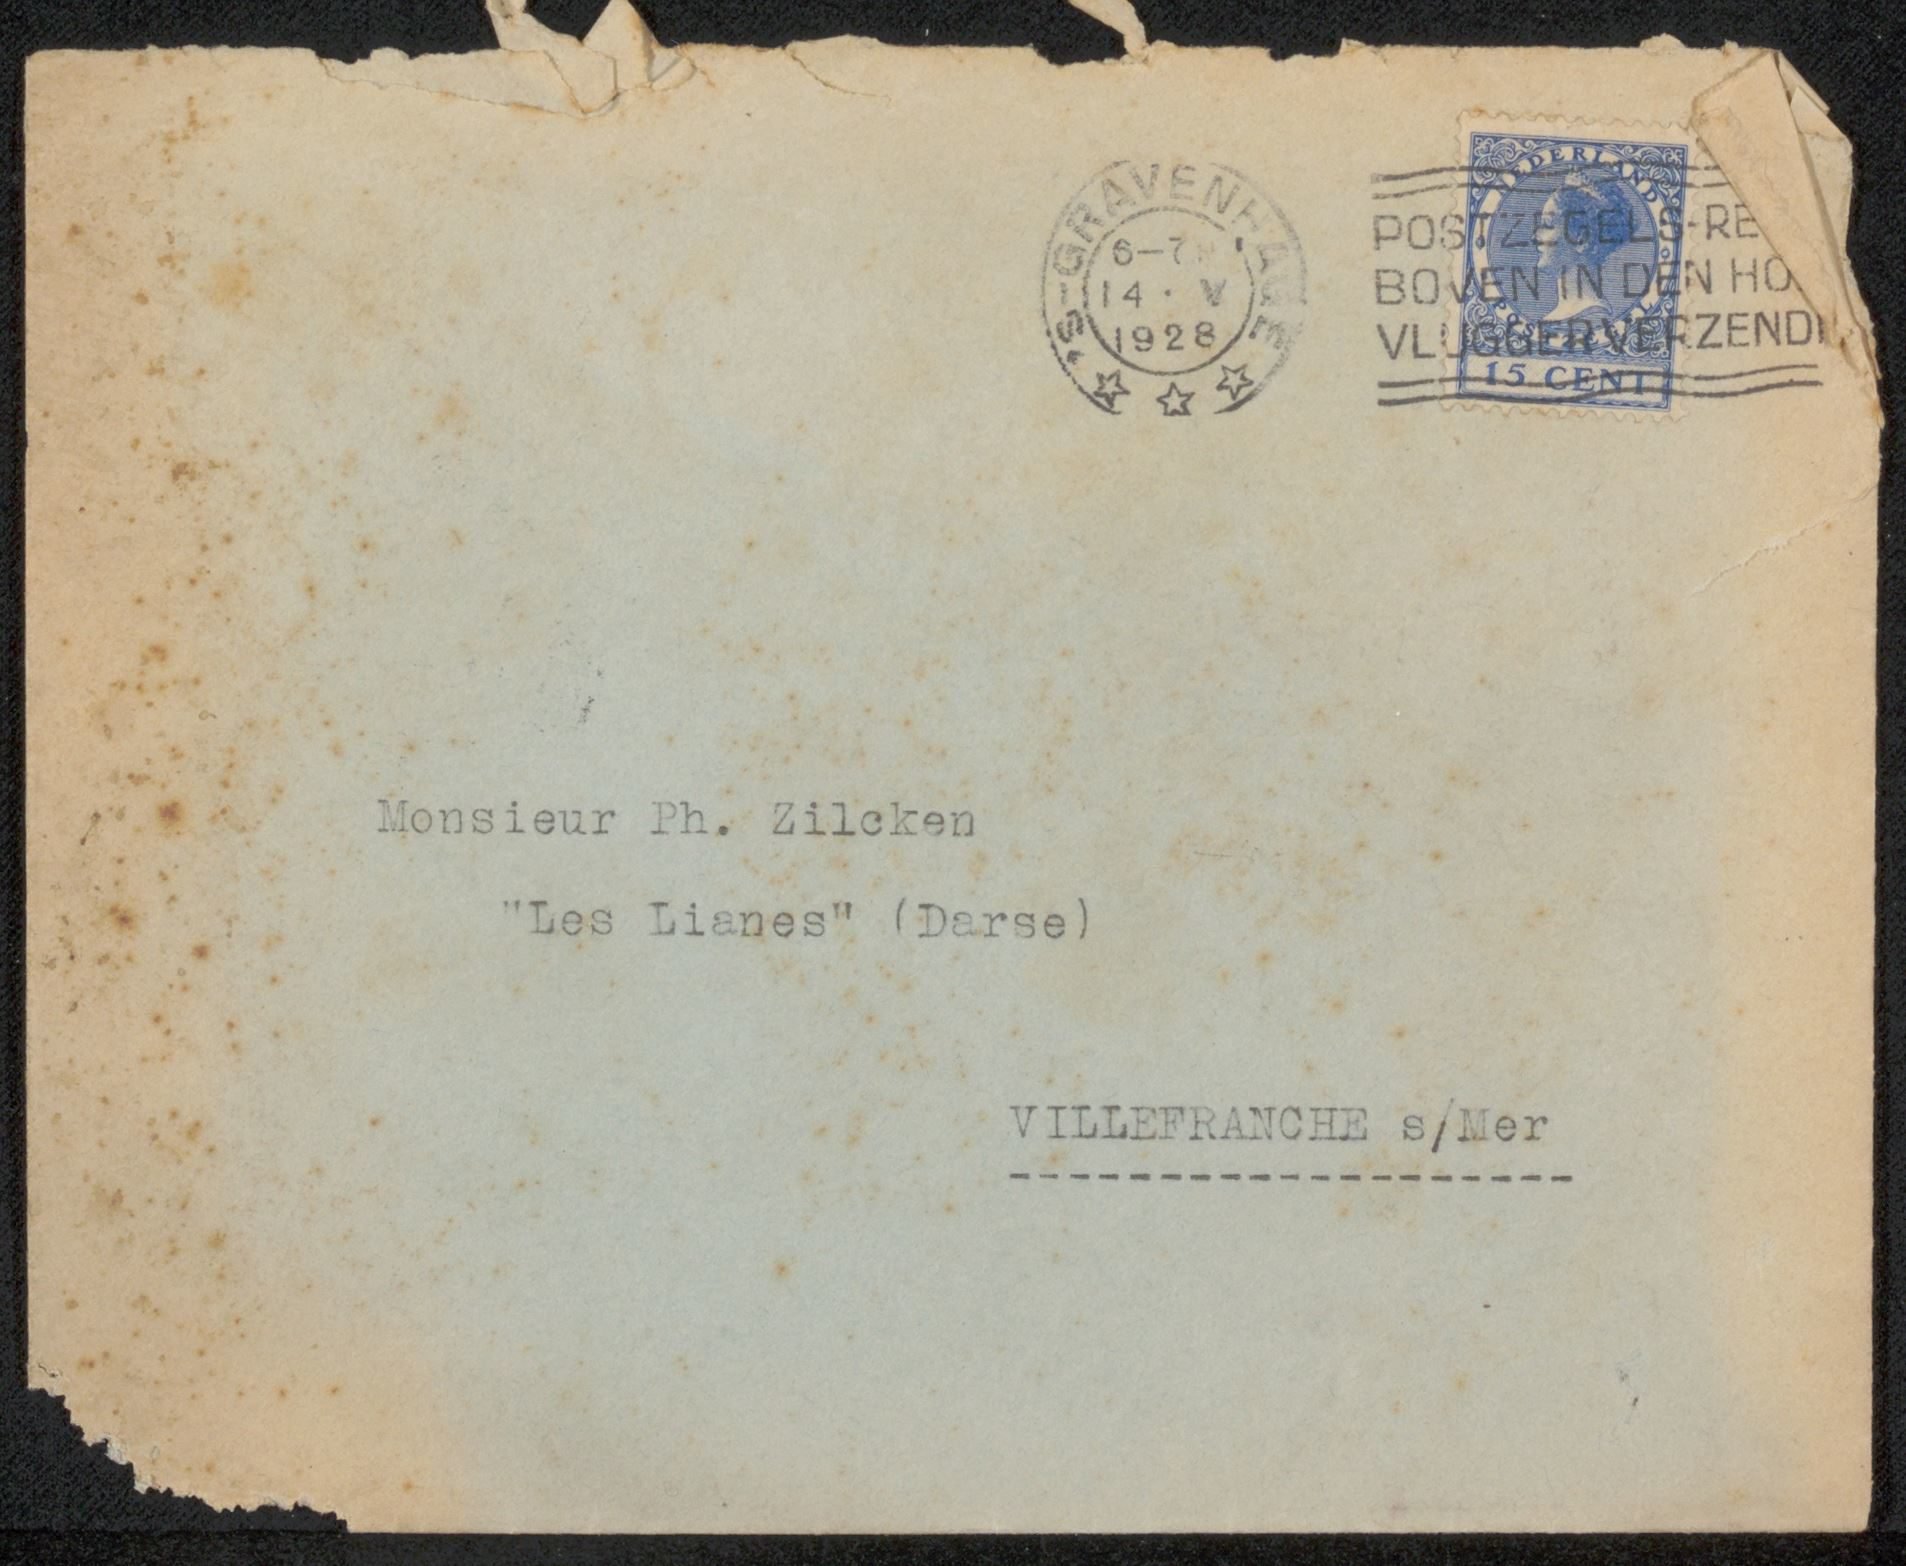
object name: envelope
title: Envelop aan Philip Zilcken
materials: ink, paper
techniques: printing, typewriting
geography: the hague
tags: the hague, painter, draughtsman, philip zilcken